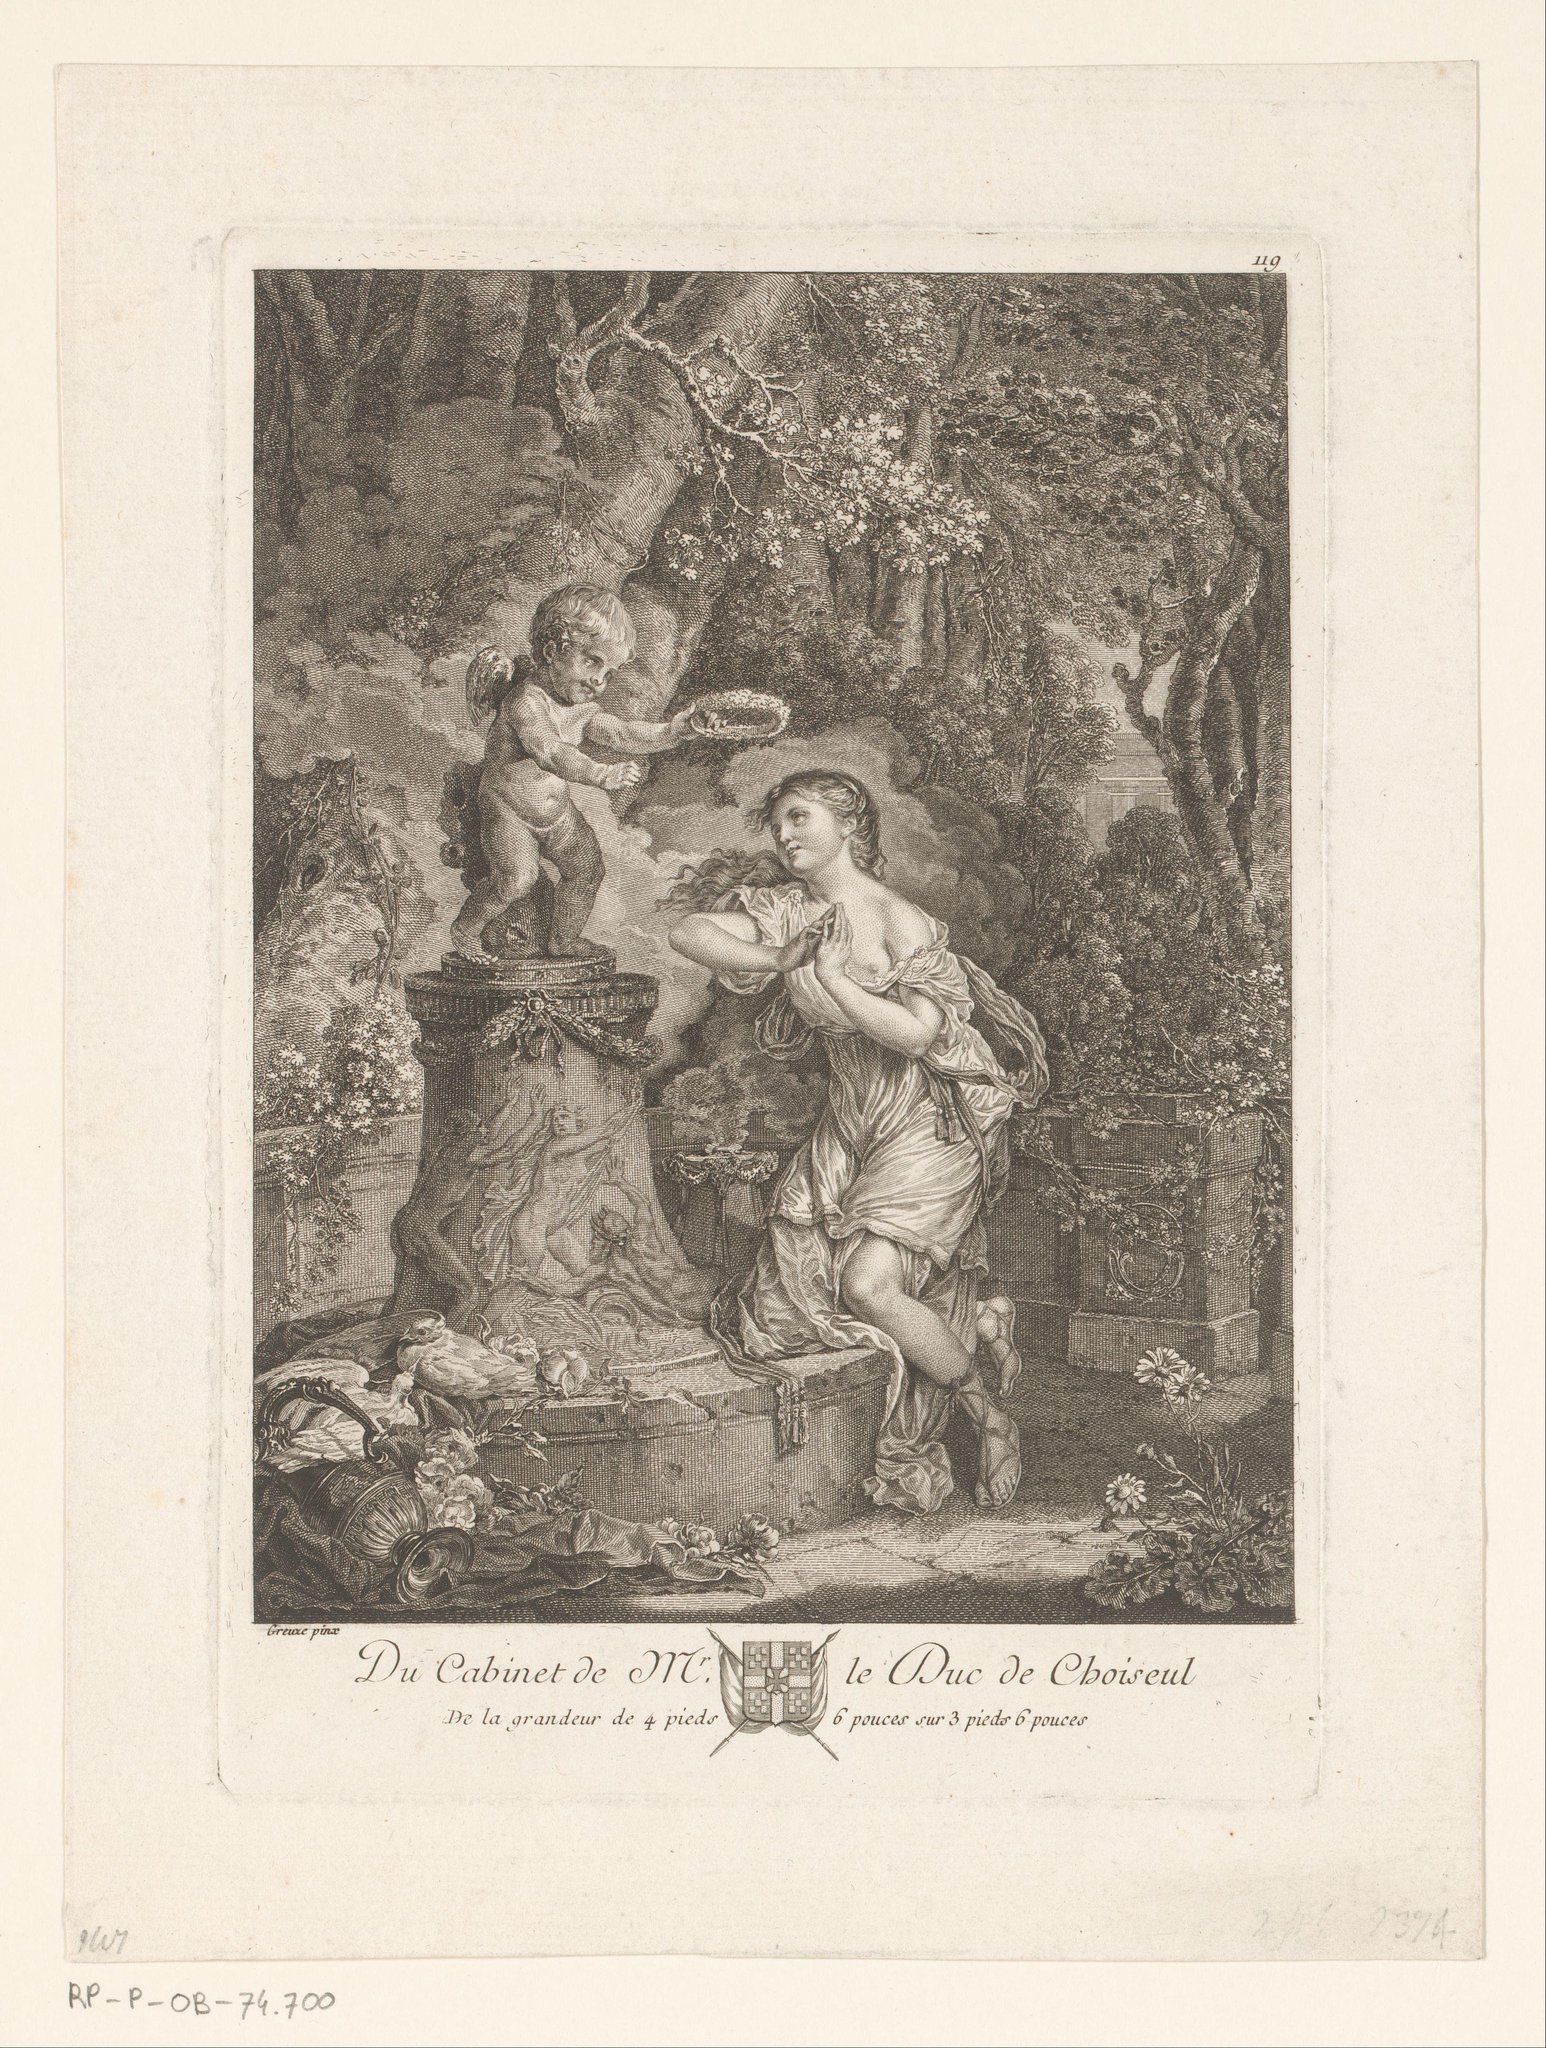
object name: print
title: Le Cabinet de Choiseul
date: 1771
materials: paper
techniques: engraving, etching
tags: (story of) cupid, amor (eros), kneeling figure, cupids: 'amores', 'amoretti', 'putti'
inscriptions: collector's mark: Lugt 240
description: Maakt deel uit van een serie met prenten naar werken uit de collectie van De Choiseul.